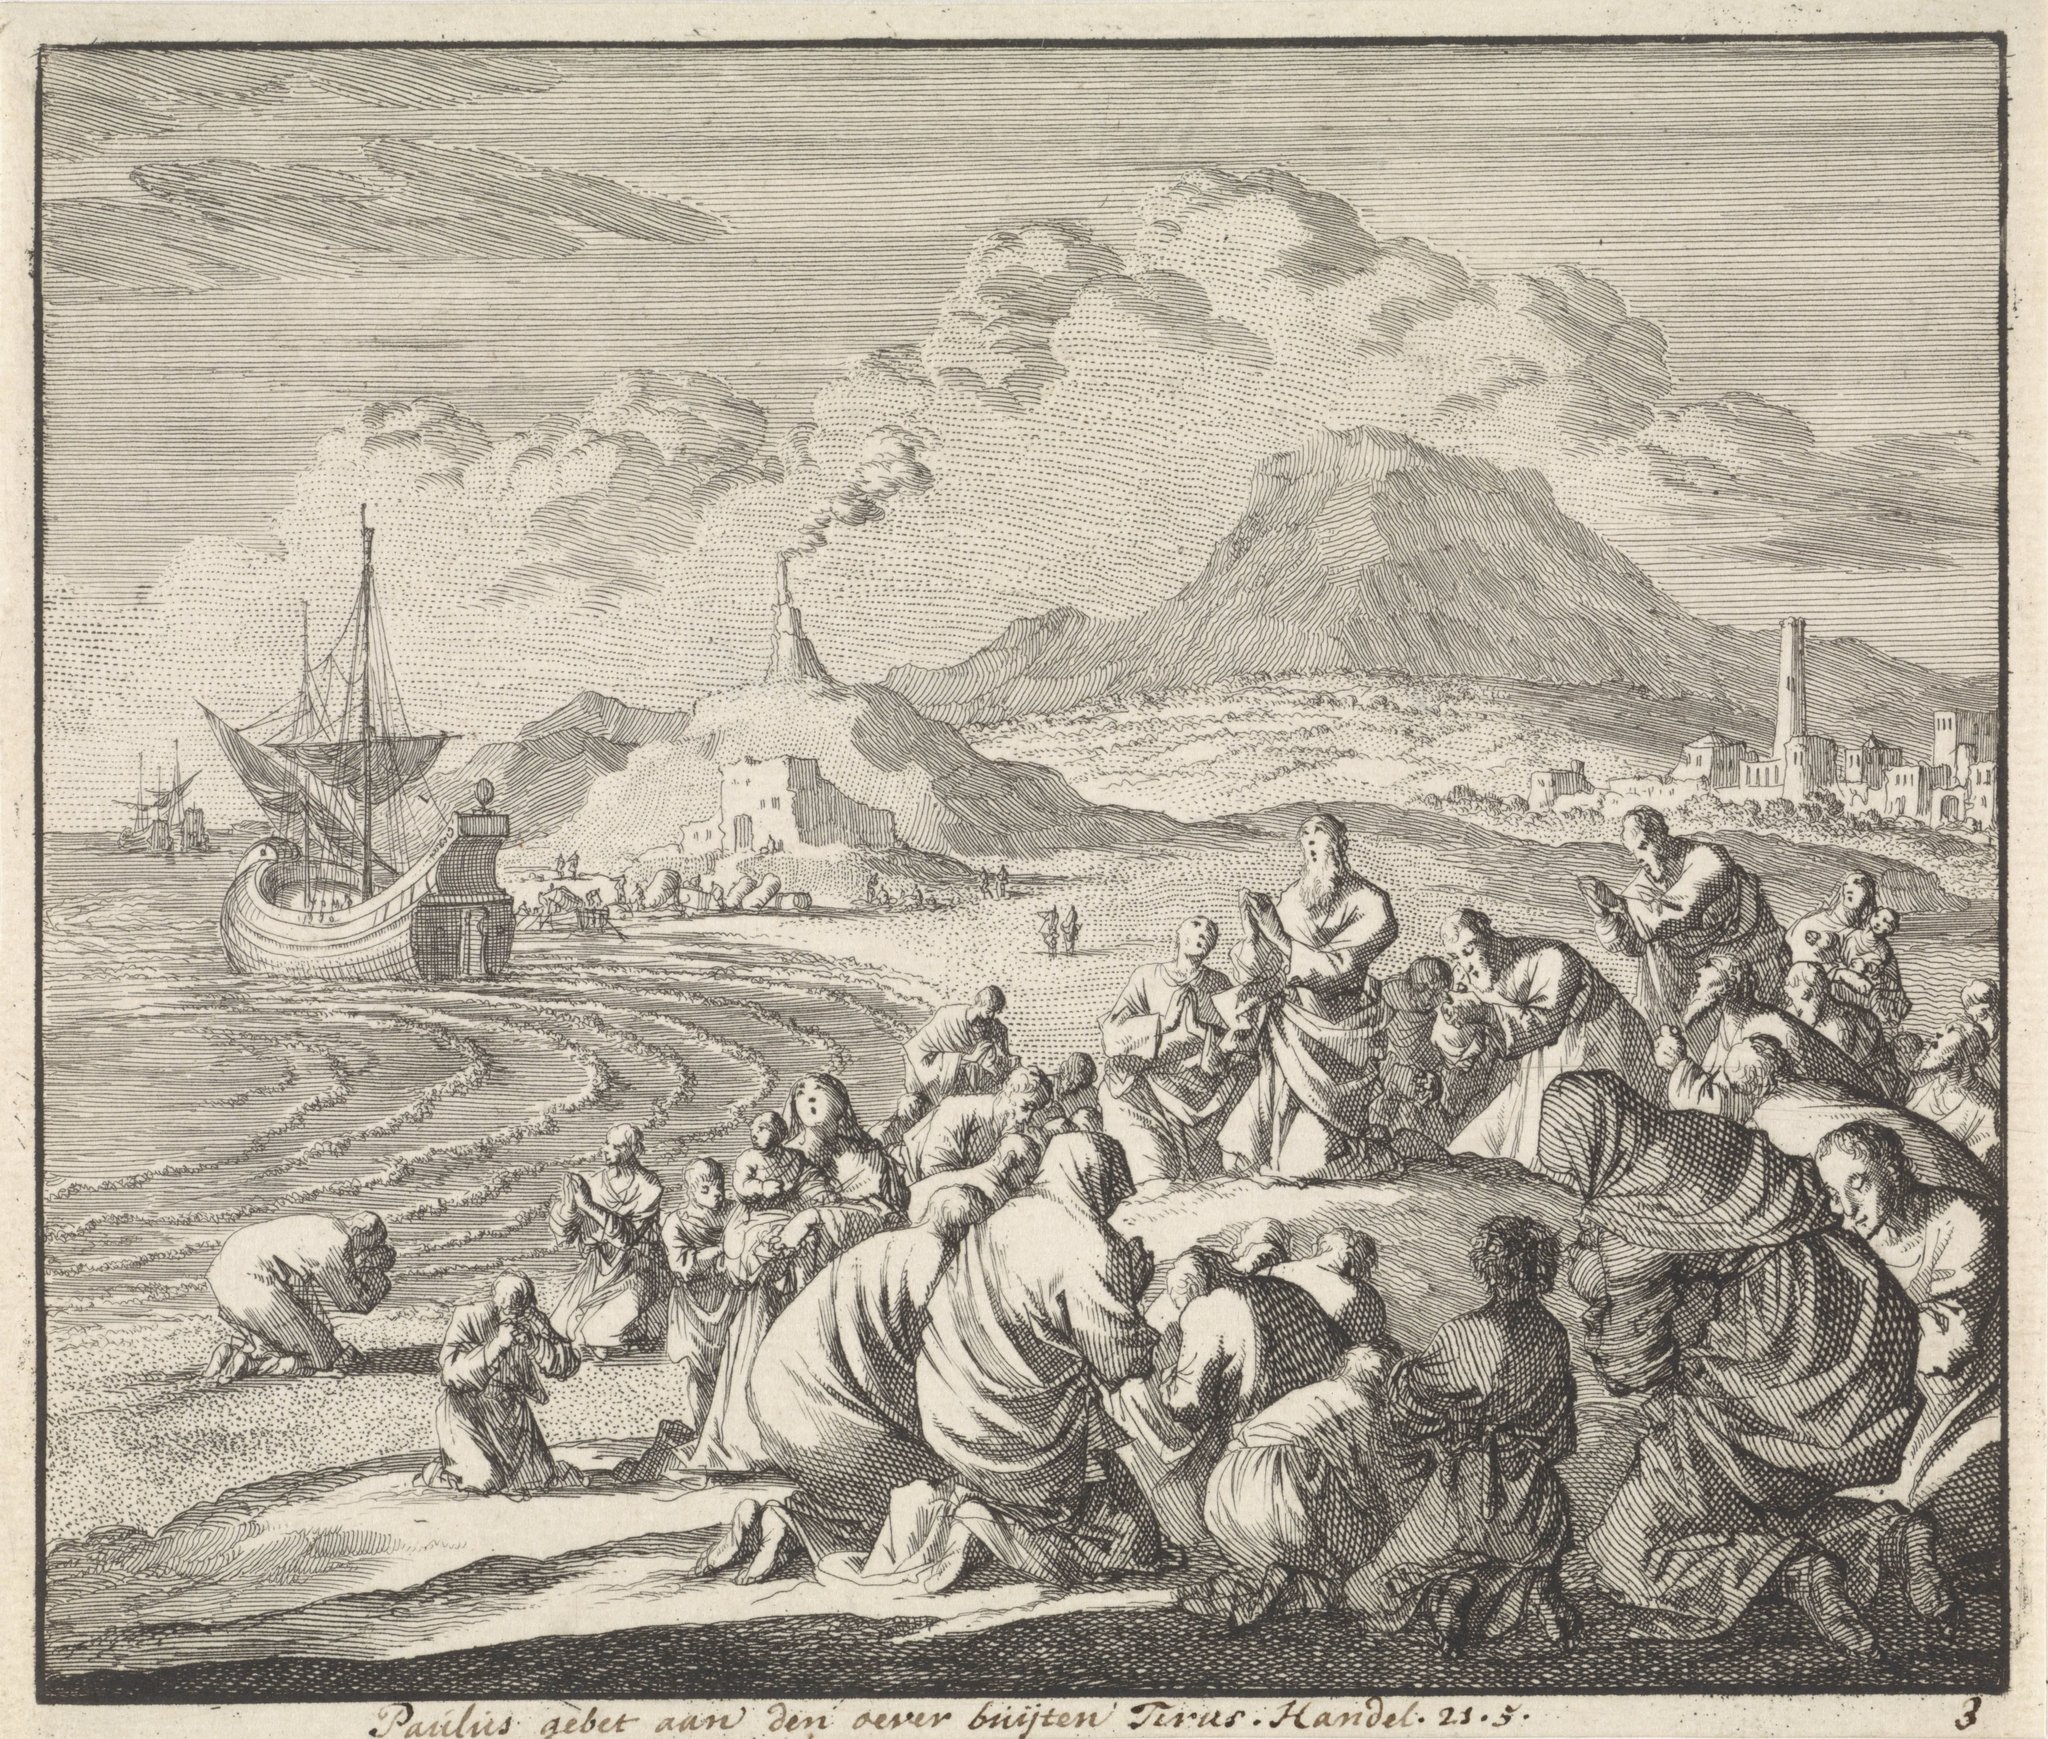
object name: print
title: Paulus bidt bij het strand van Tyrus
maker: jan luyken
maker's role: draughtsman, print maker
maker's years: 1649-1712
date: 1700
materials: paper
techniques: etching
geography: amsterdam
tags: paul in tyre; prayer and leave-taking on the shore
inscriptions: number: ‘3’, caption: ‘Paulus gebed aan den oever buijten Tirus’, collector's mark: Lugt 2228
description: Proefdruk van een boekillustratie voor Arnold, Godfried. Waare afbeelding der eerste christenen. Amsterdam: Jacobus van Hardenberg, Barent Visscher en Jacobus van Nieuweveen, 1700, dl. 1.